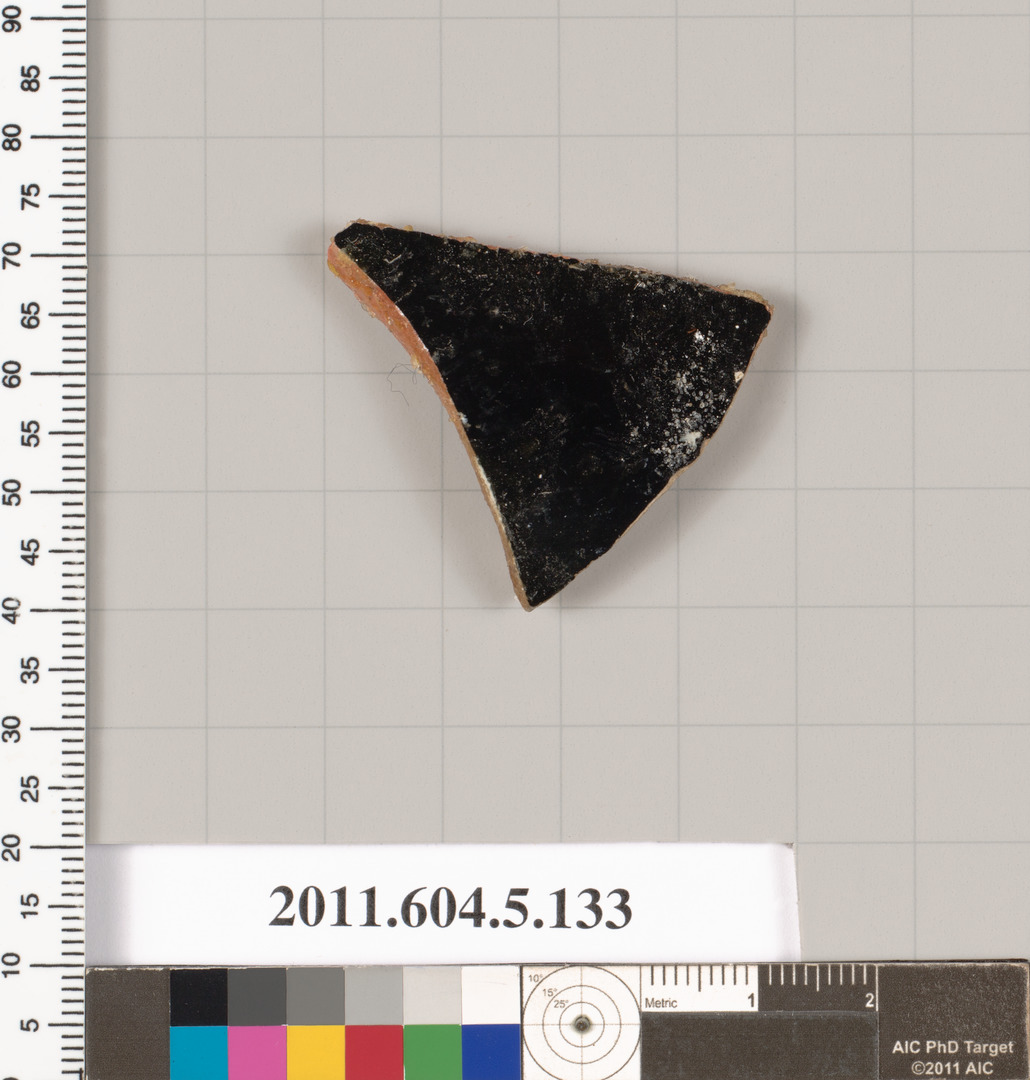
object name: kylix fragment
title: Terracotta fragment of a kylix (drinking cup)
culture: greek, attic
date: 475-451 BCE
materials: terracotta